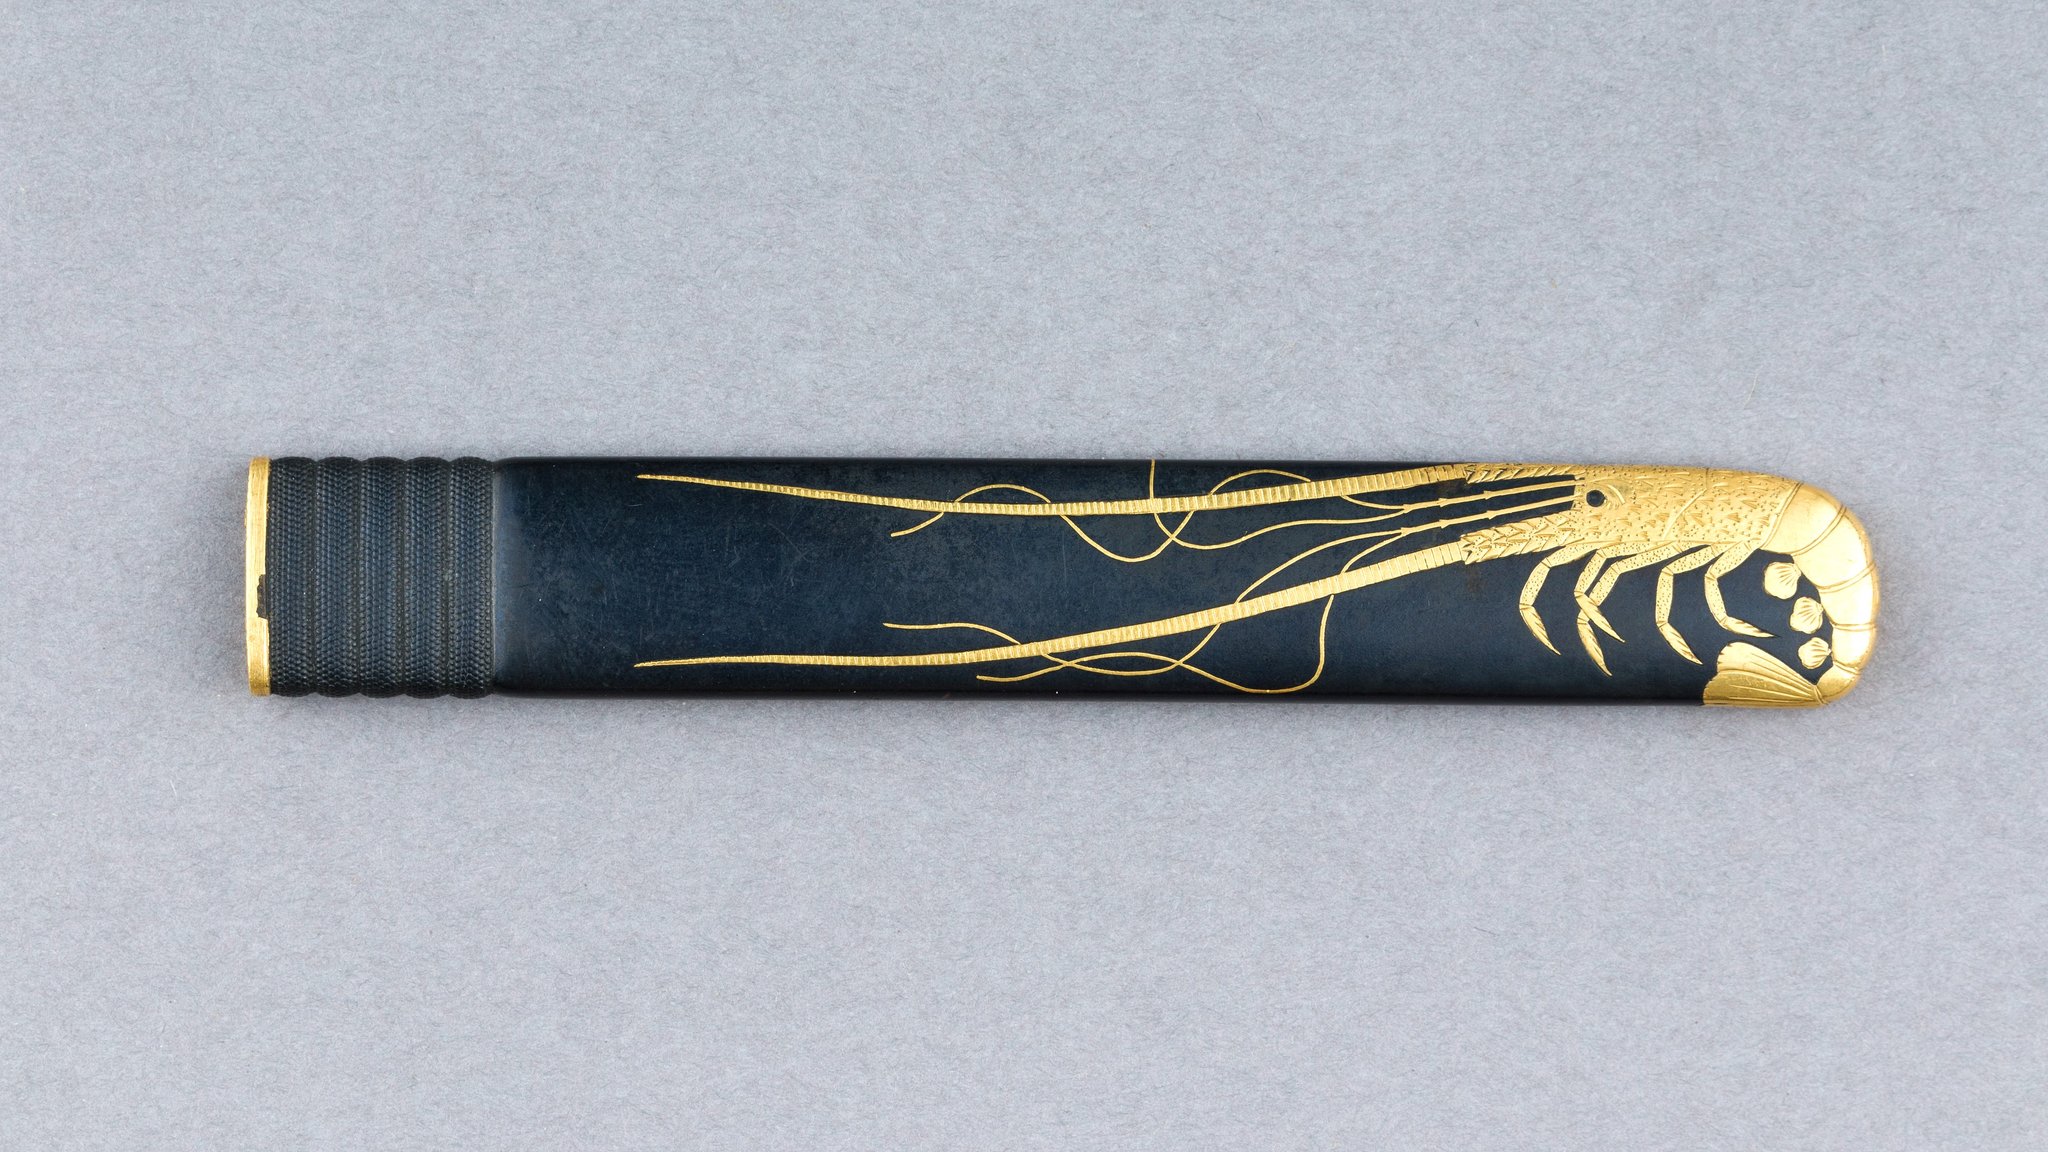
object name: knife handle kozuka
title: Knife Handle (Kozuka)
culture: japanese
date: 1615-1868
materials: gold alloy, gold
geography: japan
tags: lobsters